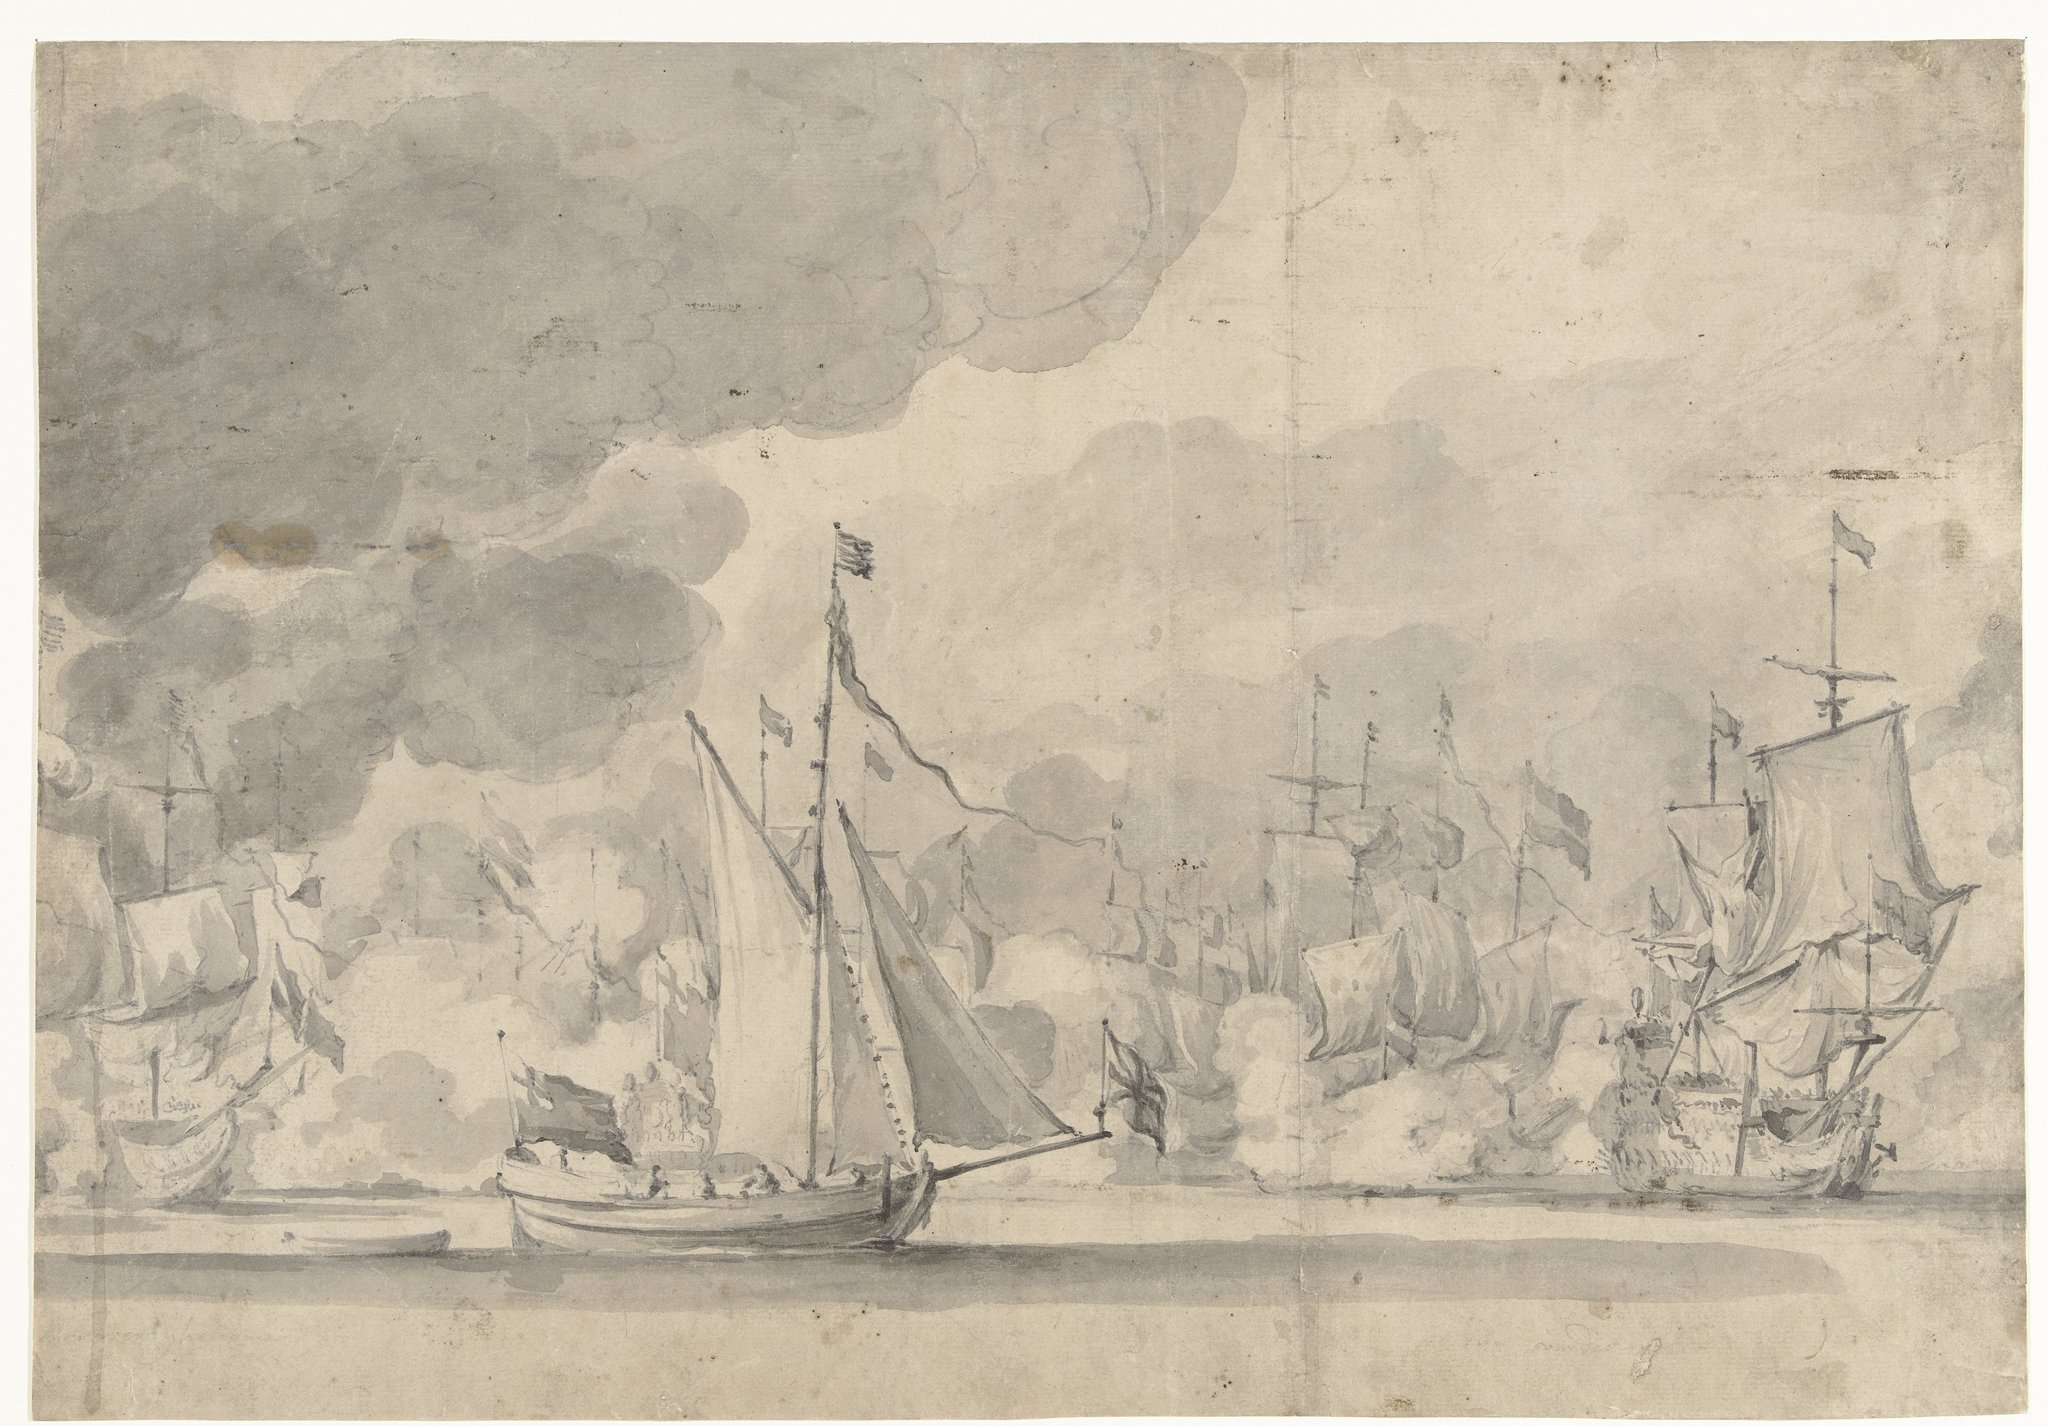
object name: drawing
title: Zeeslag bij Lowestoft op 13 Juni 1665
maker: willem van de velde (i)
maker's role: draughtsman, painter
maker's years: 1611-1693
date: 1665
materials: paper, pencil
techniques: brush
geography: northern netherlands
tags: james stuart (hertog van york), jacob baron van wassenaer heer van obdam, sailing-ship, sailing-boat, battle (+ sailing-ships), navy (+ sailing-ships), battle of lowestoft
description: Zeegevecht voor Lowestoft (Lestoffe) tussen de Engelsen onder de hertog van York en de Nederlanders onder Wassenaer van Obdam. Uitvoerige voorstelling op zes aaneensluitende bladen, blad 3.